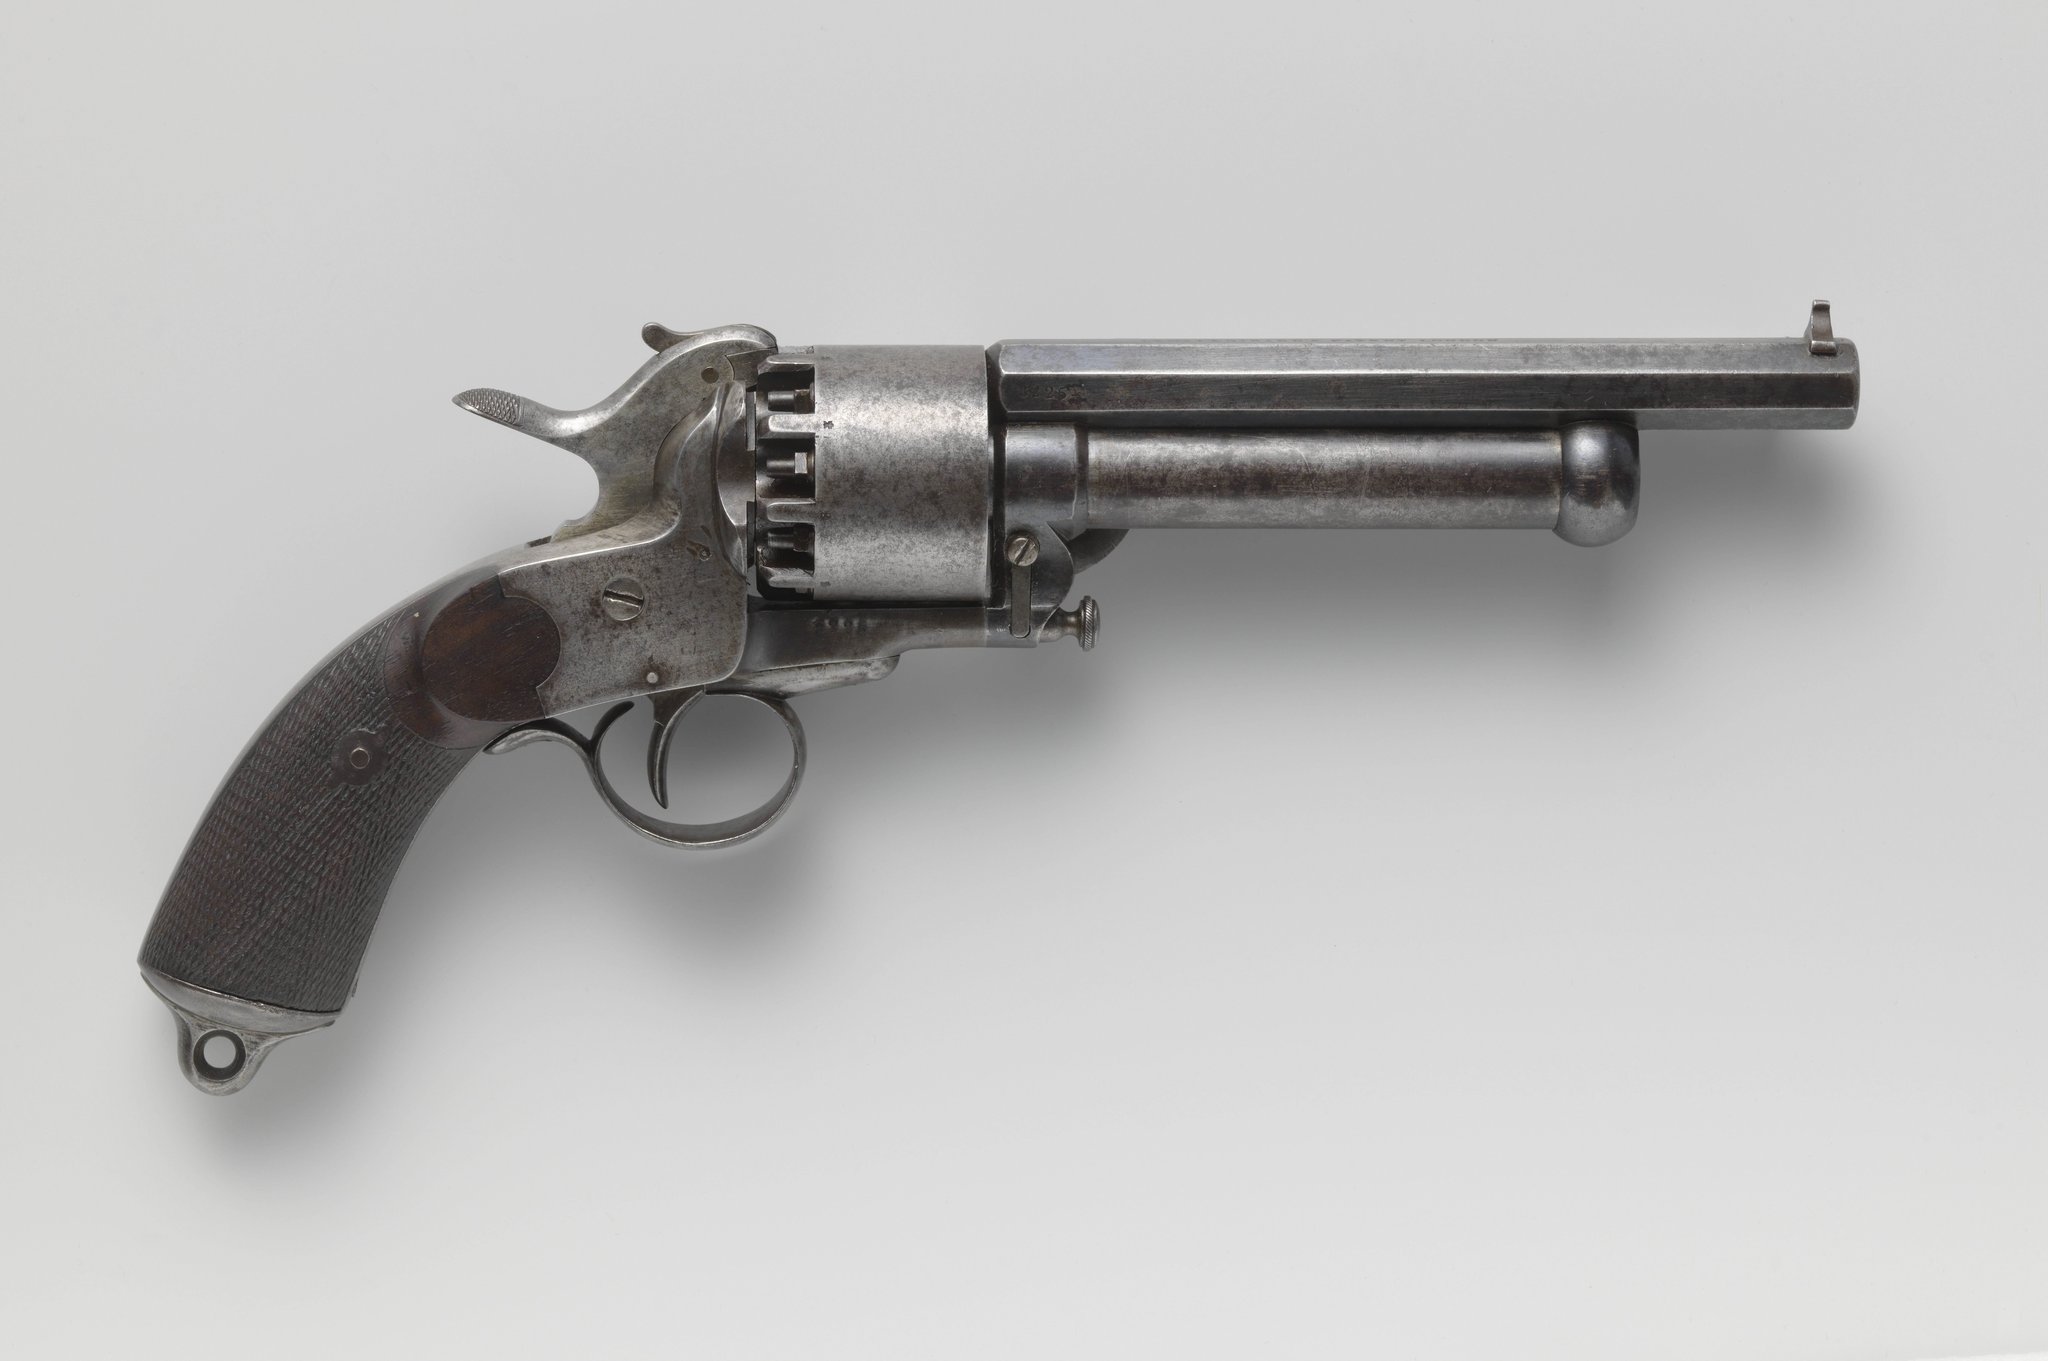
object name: percussion revolver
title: Revolver uit Atjeh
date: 1862-1881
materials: iron, wood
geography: london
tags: atjeh, atjeh-oorlog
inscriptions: mark: ‘Lemat & Girard's Patent London’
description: Revolver, in Atjeh veroverd of buitgemaakt. Percussiesysteem, cylinder met negen kamers en twee lopen. Met haan waarvan de kop basculeert en neerslaat op een 10. schoorsteentje, corresponderende met de 2e of achterliggende loop. Gemerkt no. 8225. Op de loop: Lemat & Girard's Patent London.